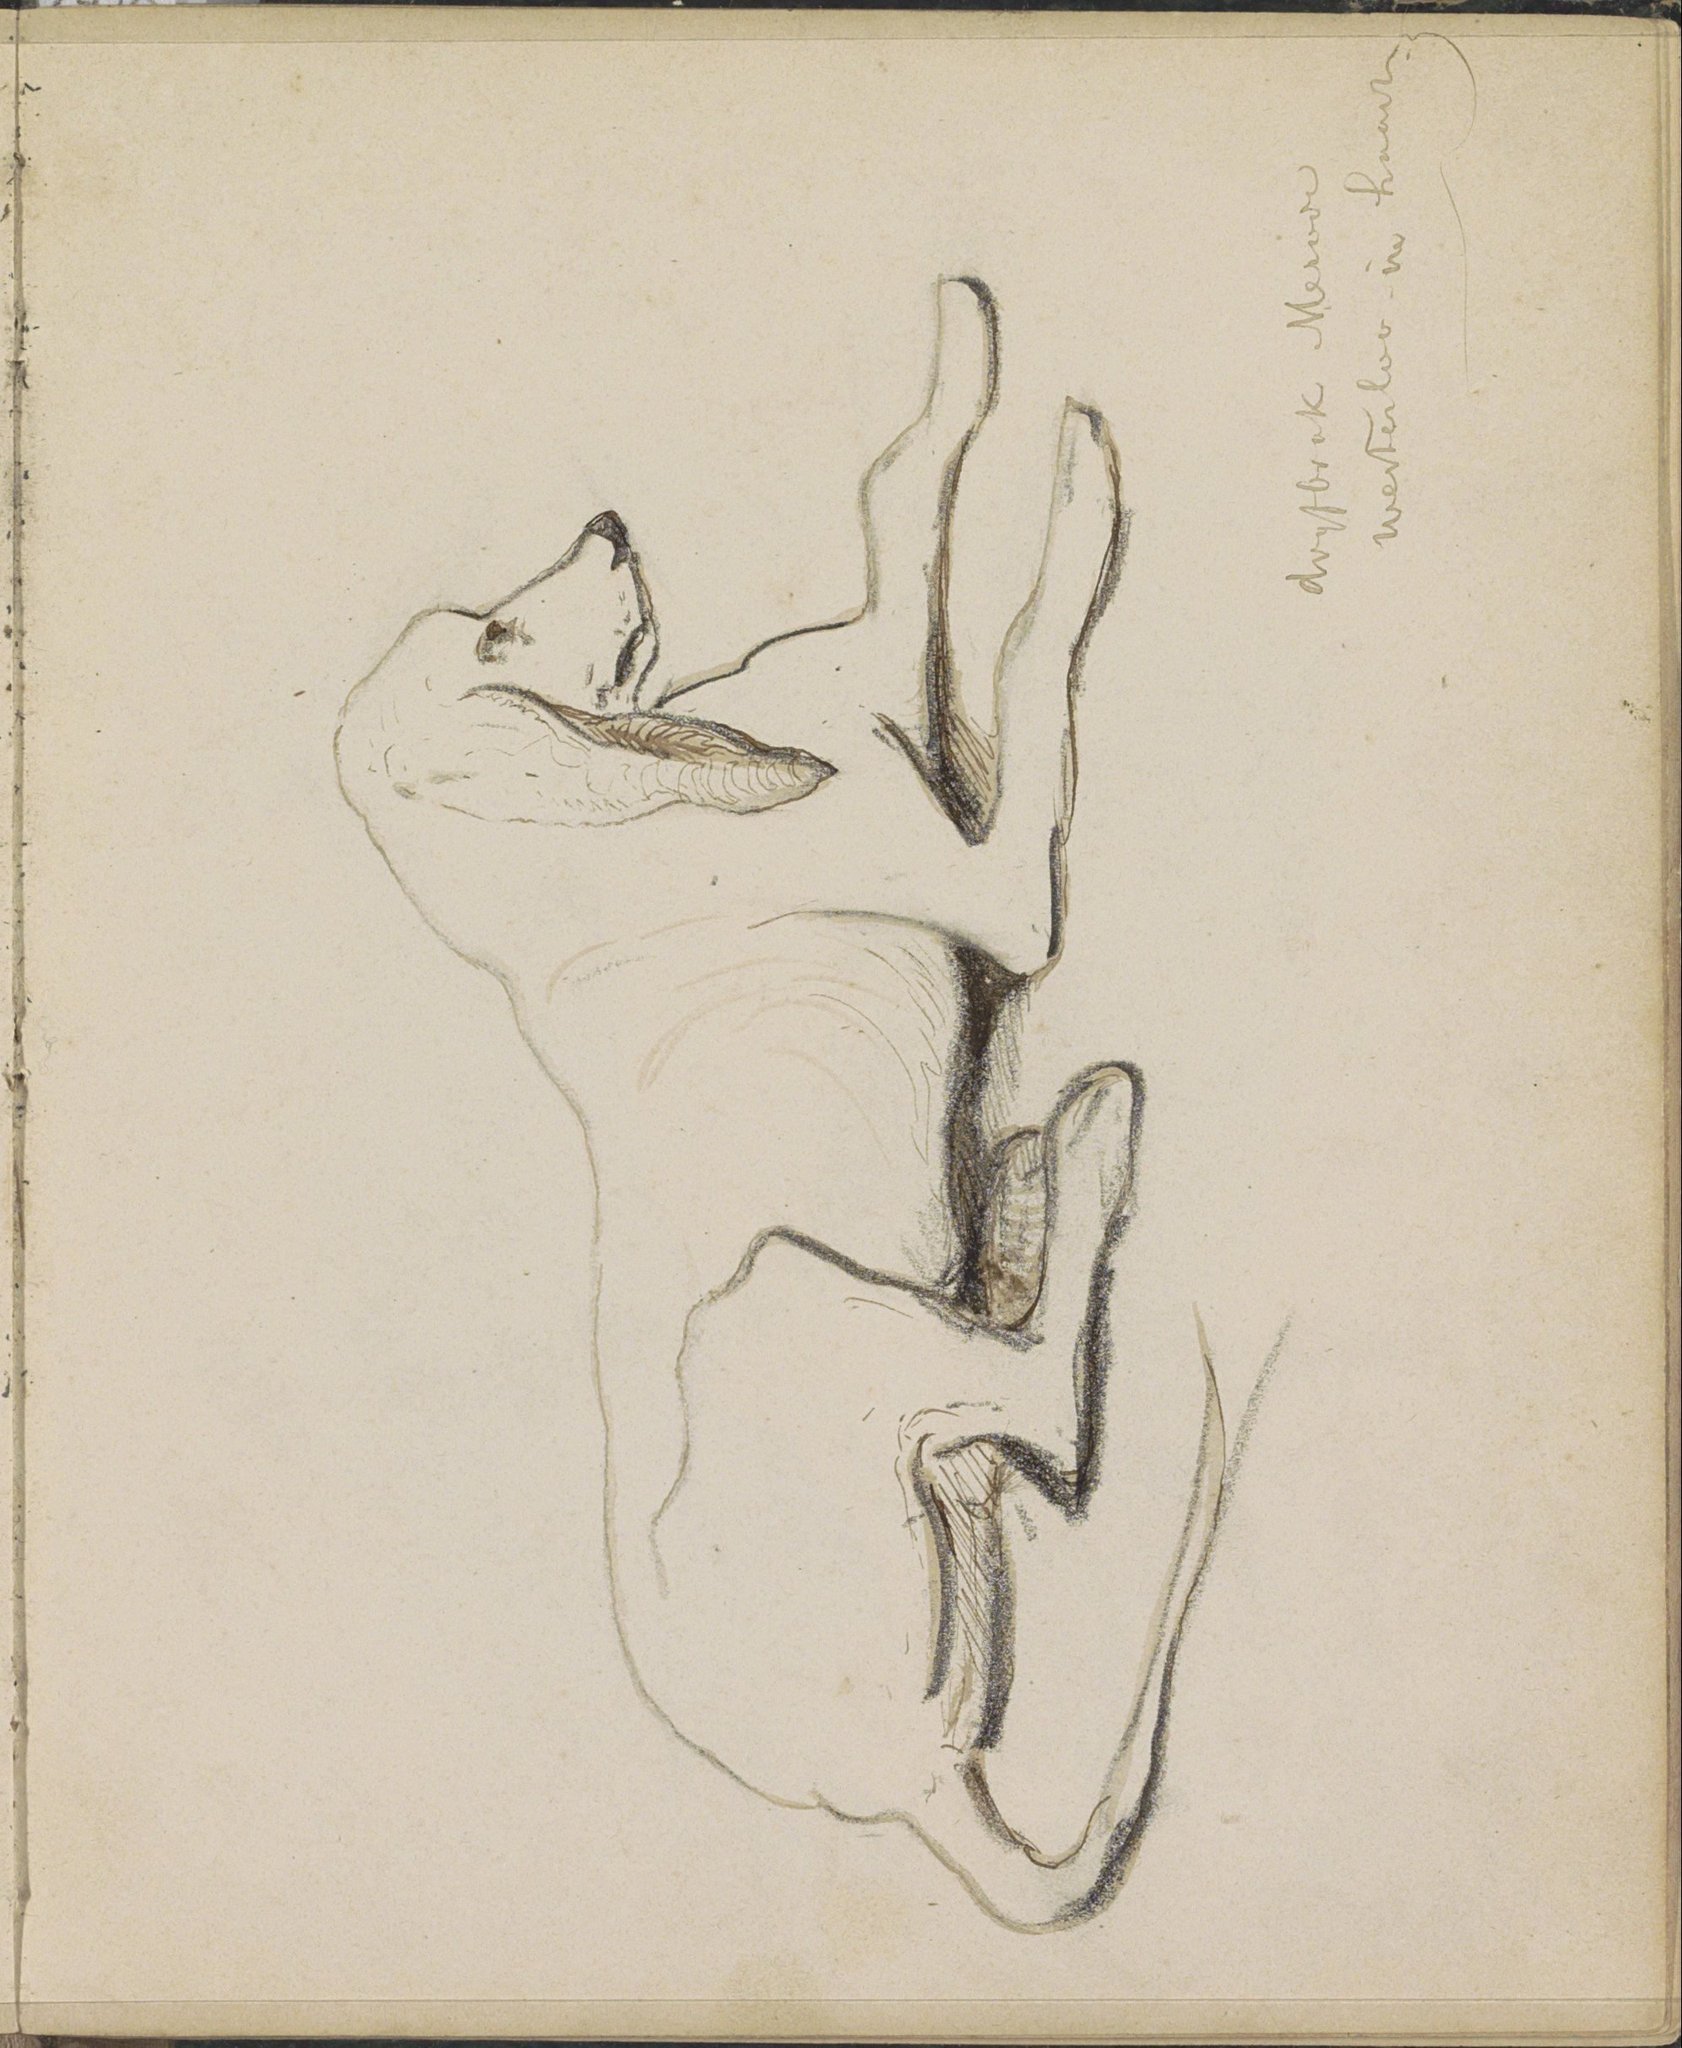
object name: sketchbook leaf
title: Liggende hond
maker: johannes tavenraat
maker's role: draughtsman, painter, print maker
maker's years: 1809-1881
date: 1841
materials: ink, paper, pencil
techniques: pen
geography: westerlo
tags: dog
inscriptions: date and inscription: ‘drijfbrak Merode/ Westerloo in haar[...]’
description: Blad 20 recto uit een schetsboek met 87 bladen.